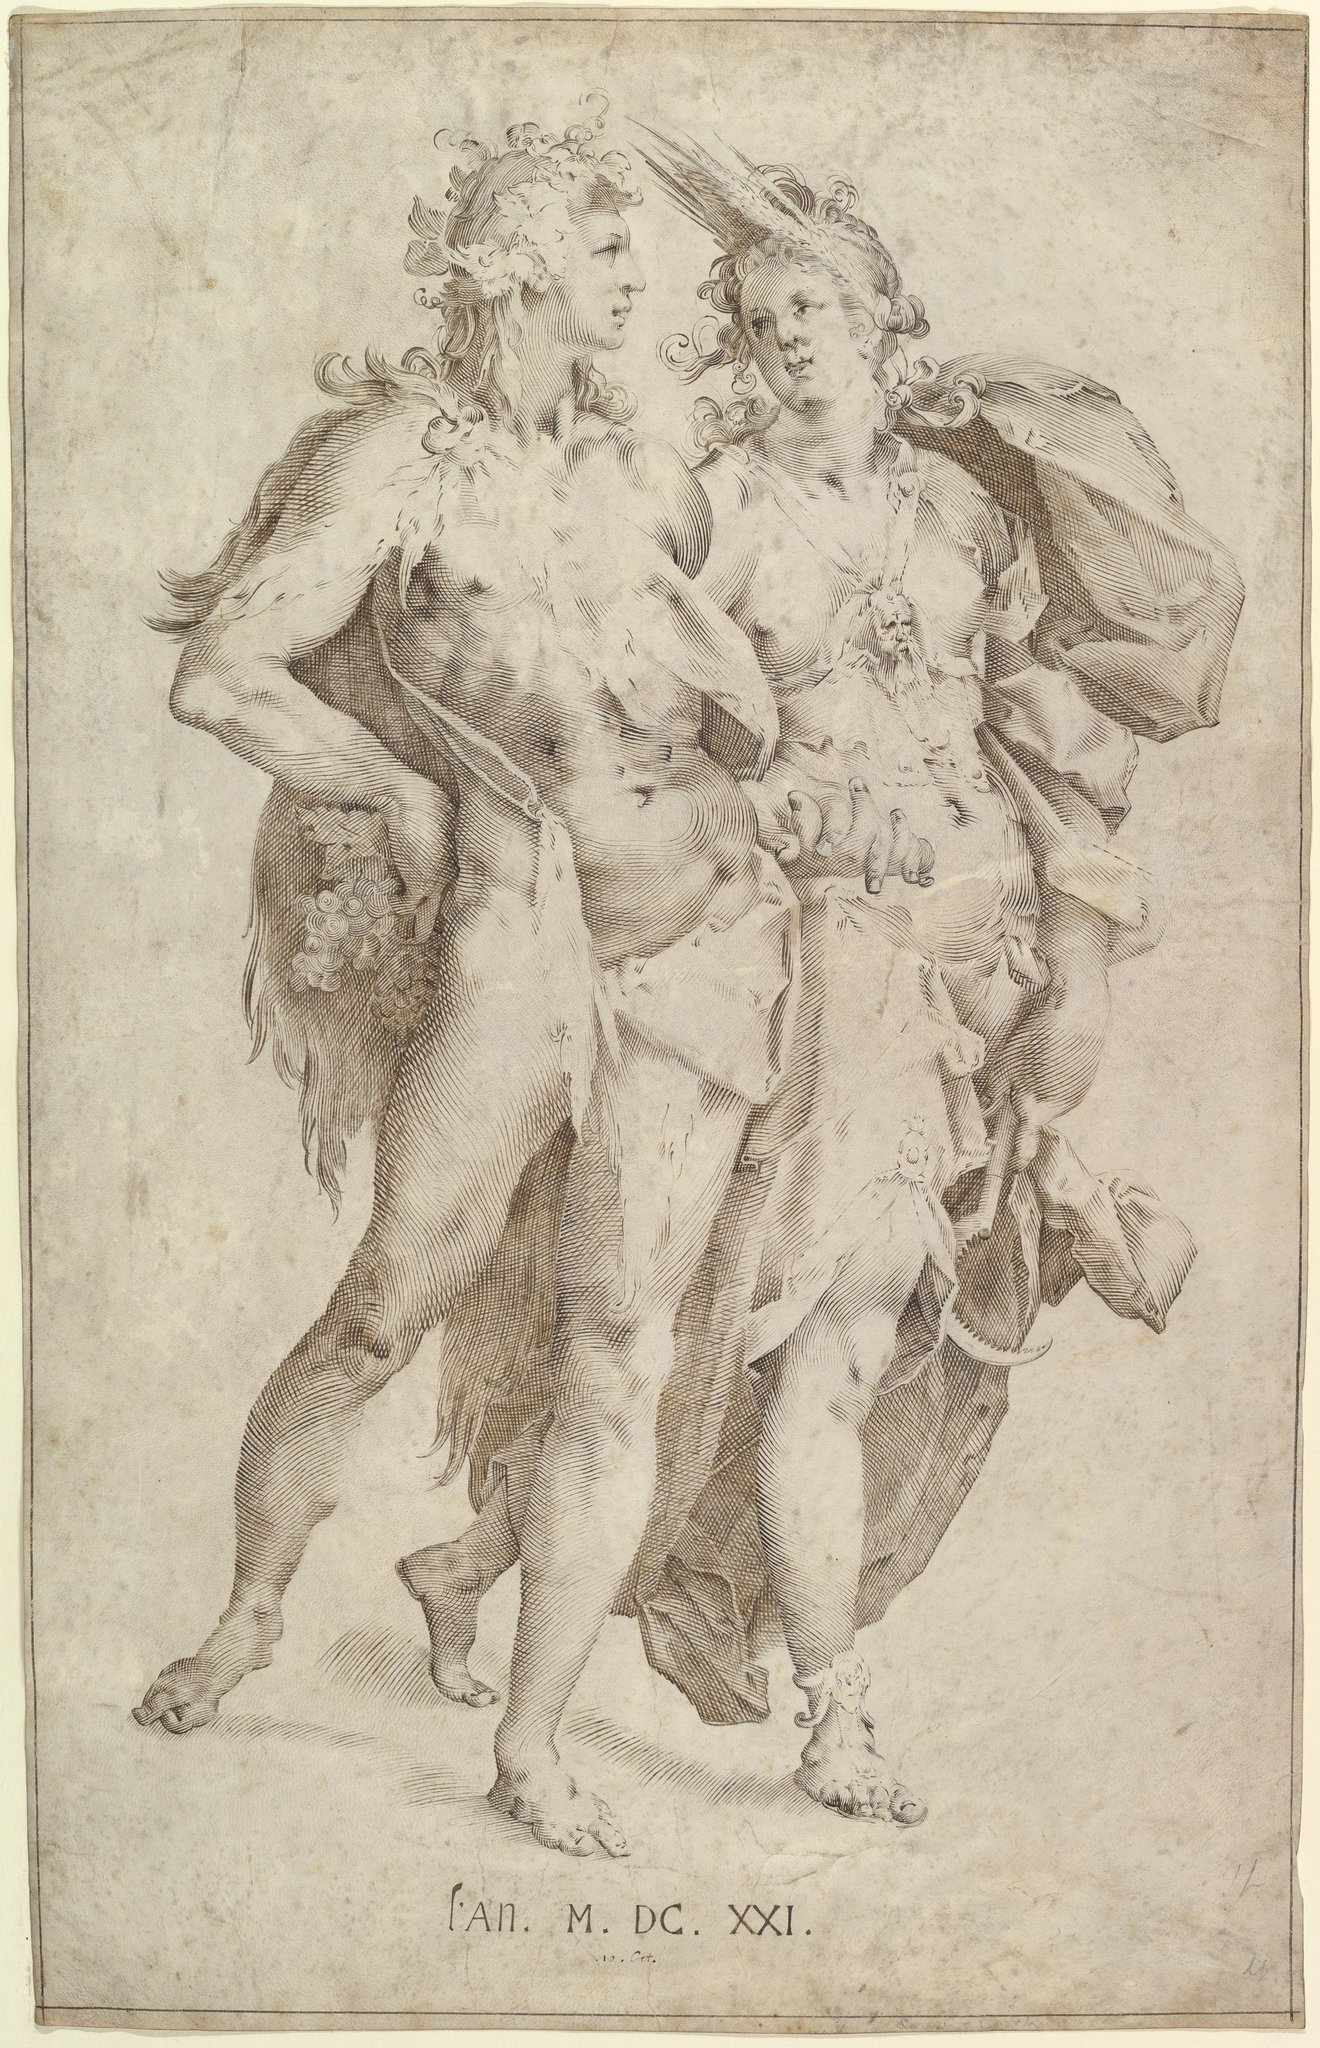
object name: drawing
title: Ceres and Bacchus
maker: anonymous, dutch, 17th century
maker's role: artist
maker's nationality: dutch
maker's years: 1600-1700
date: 1621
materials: ink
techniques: pen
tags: bacchus,ceres